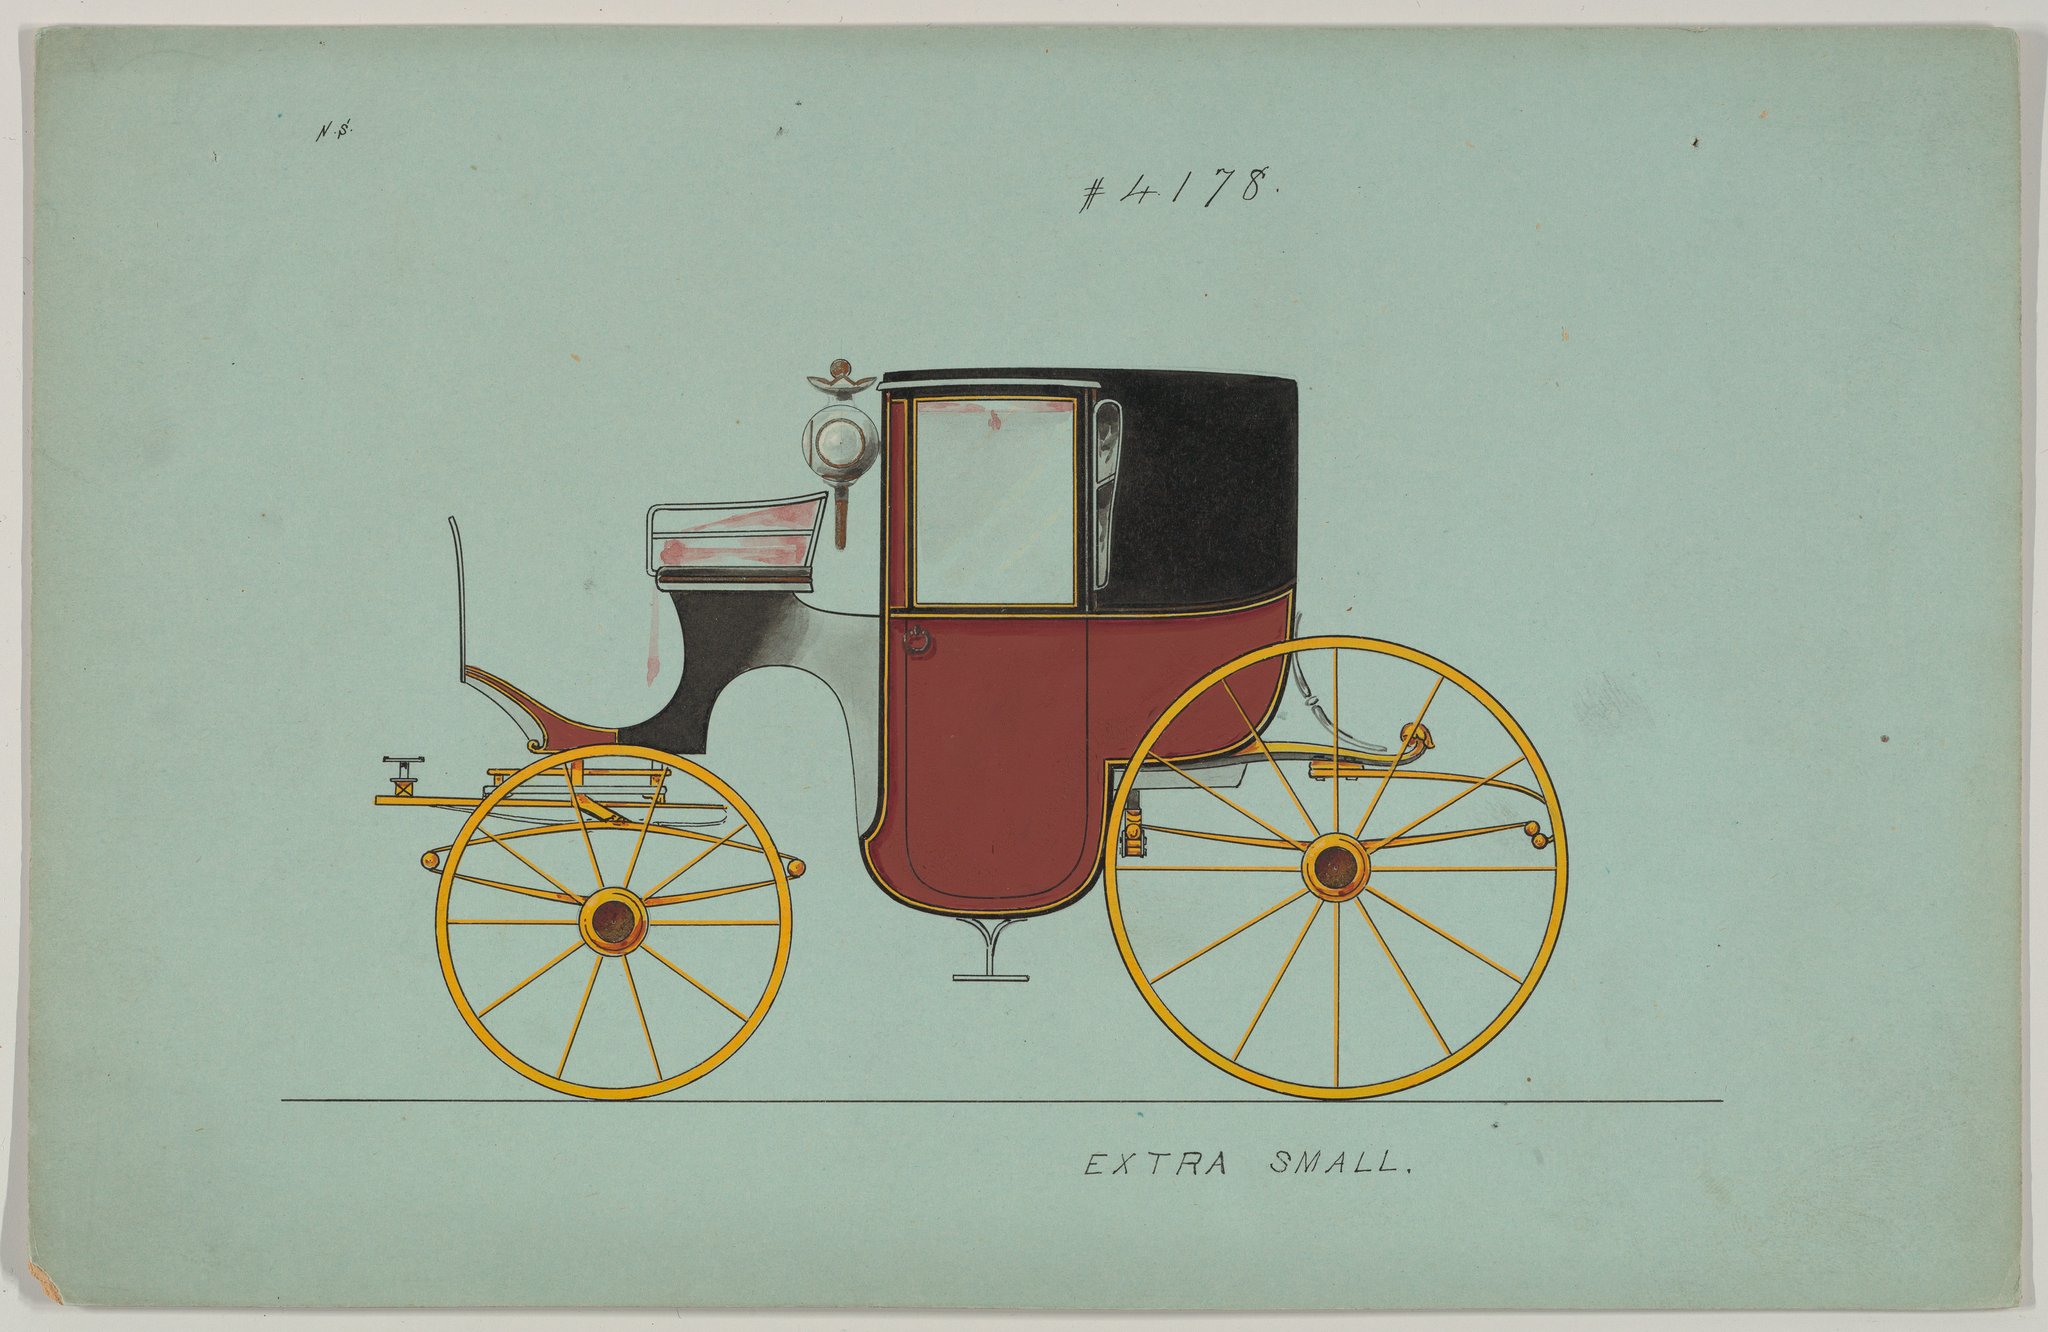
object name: drawing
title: Brougham #4178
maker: brewster & co.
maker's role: manufacturer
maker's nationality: american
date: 1892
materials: gouache, ink, watercolor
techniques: pen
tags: carriages